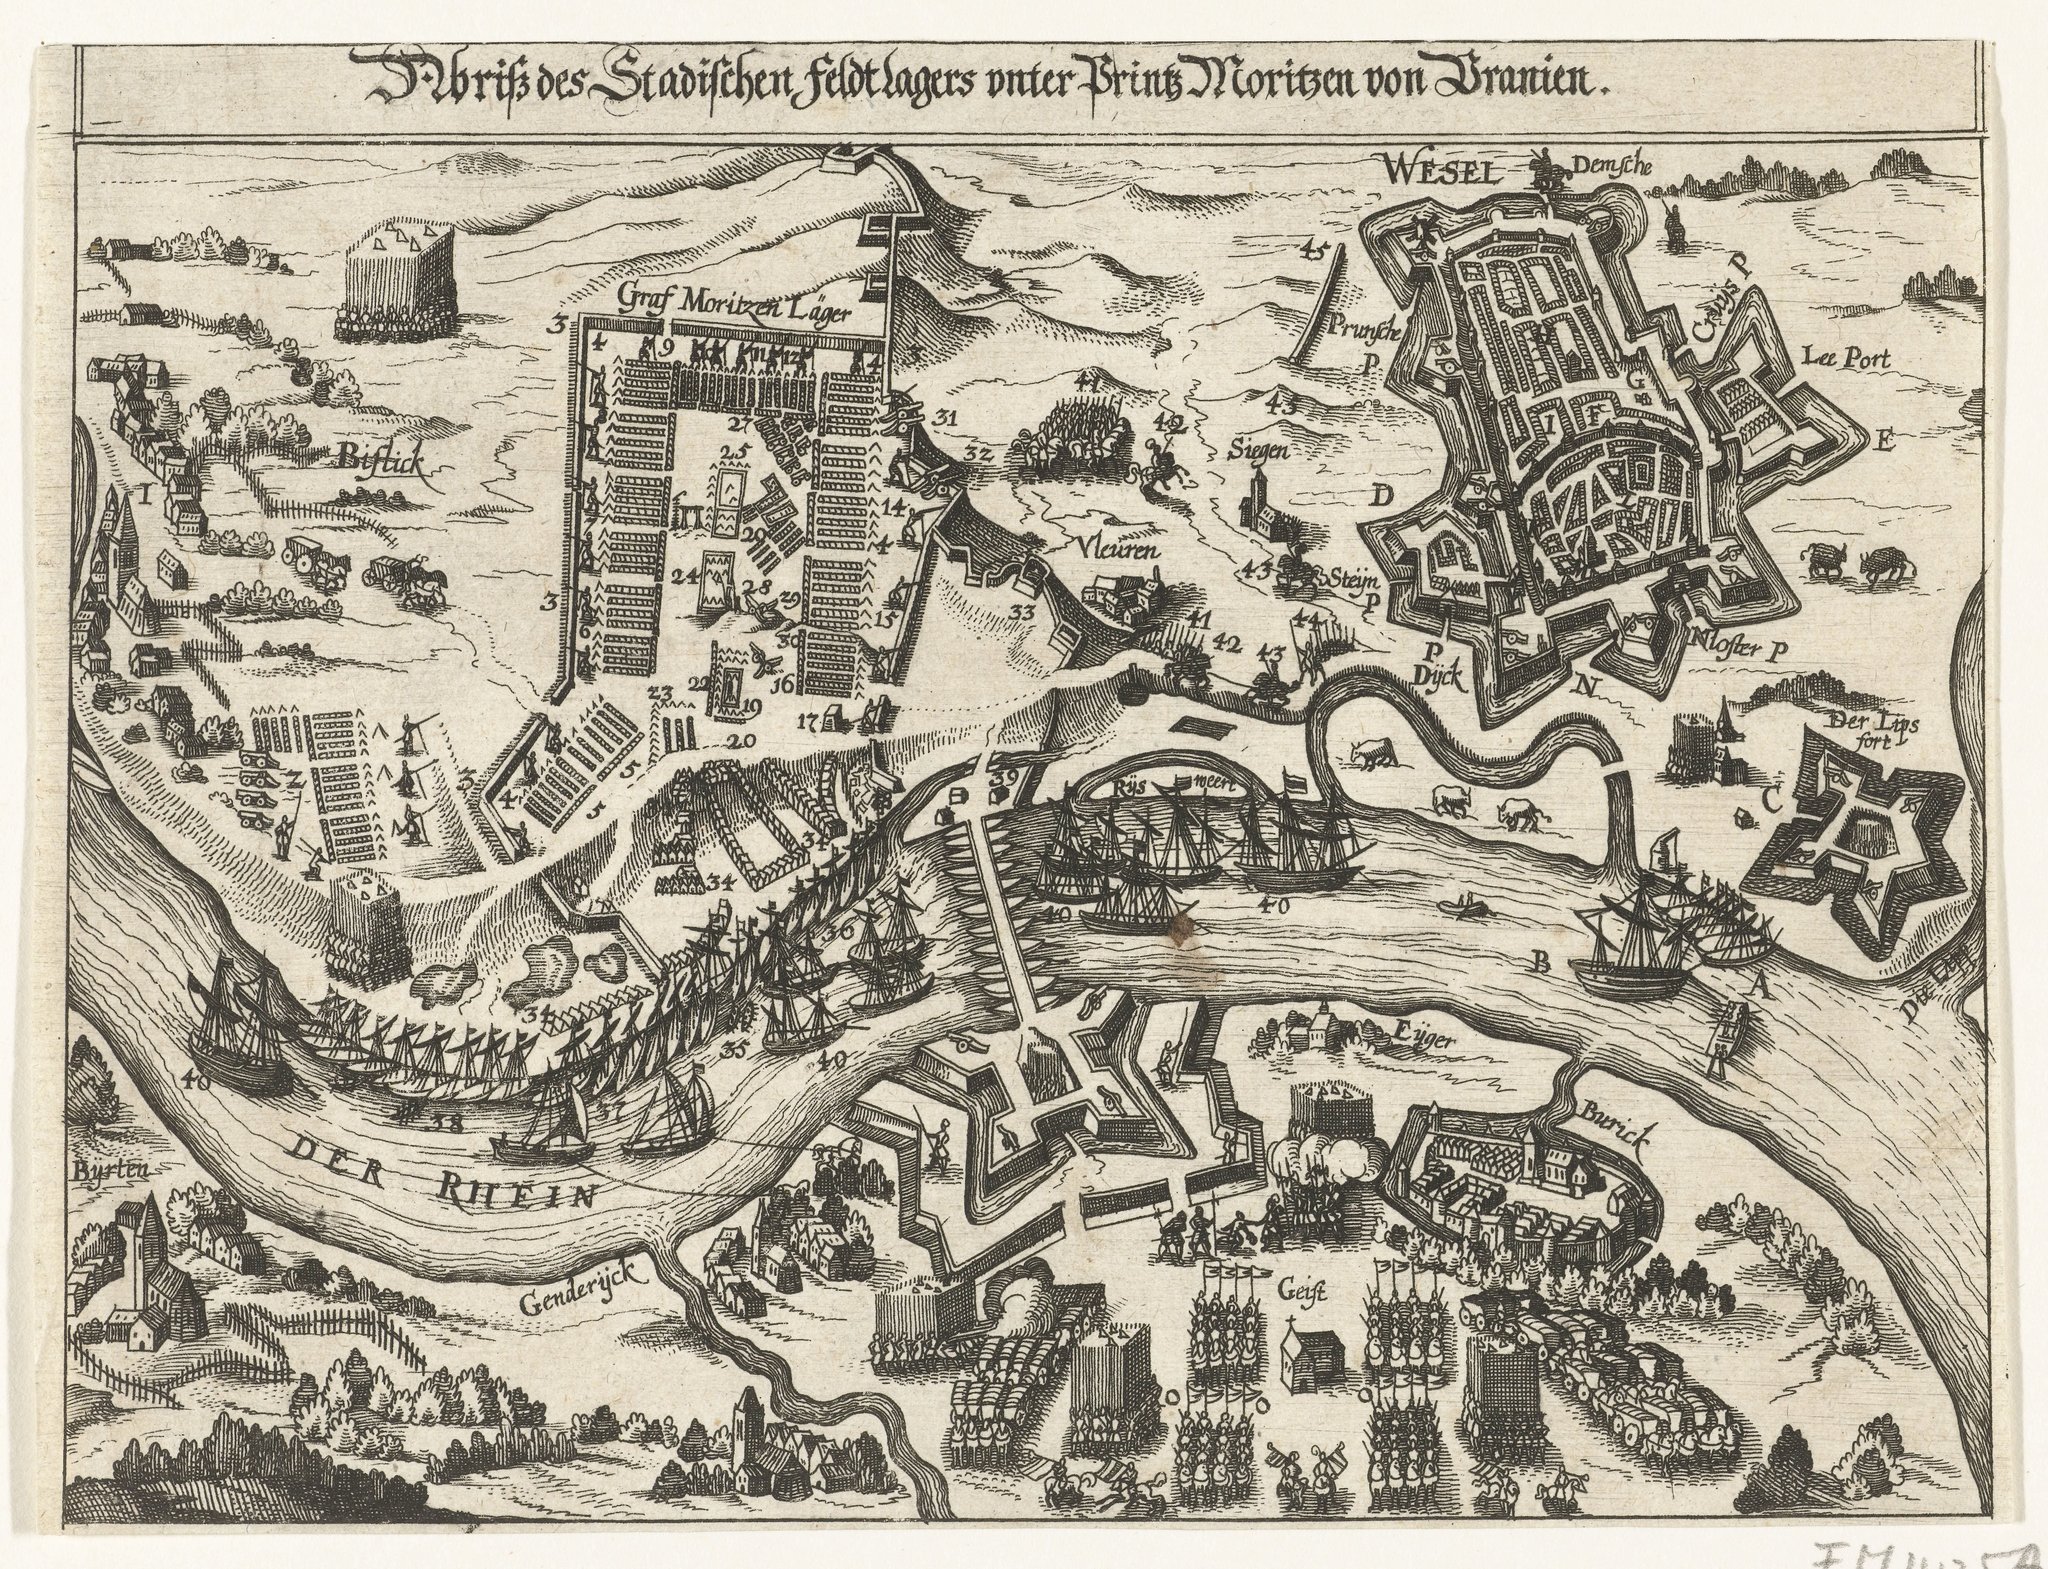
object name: print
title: Het Staatse leger onder Maurits gelegerd bij Wesel, 1620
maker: Anonymous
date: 1621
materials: paper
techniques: etching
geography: germany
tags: the hague, maurice (prince of orange), troop movements, transportation, maps of separate countries or regions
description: Kaart van Wesel aan de Rijn en omgeving met de legerplaats van het Staatse leger onder Maurits, 1620. Tocht van prins Maurits tegen Spinola, 15-23 augustus 1620.